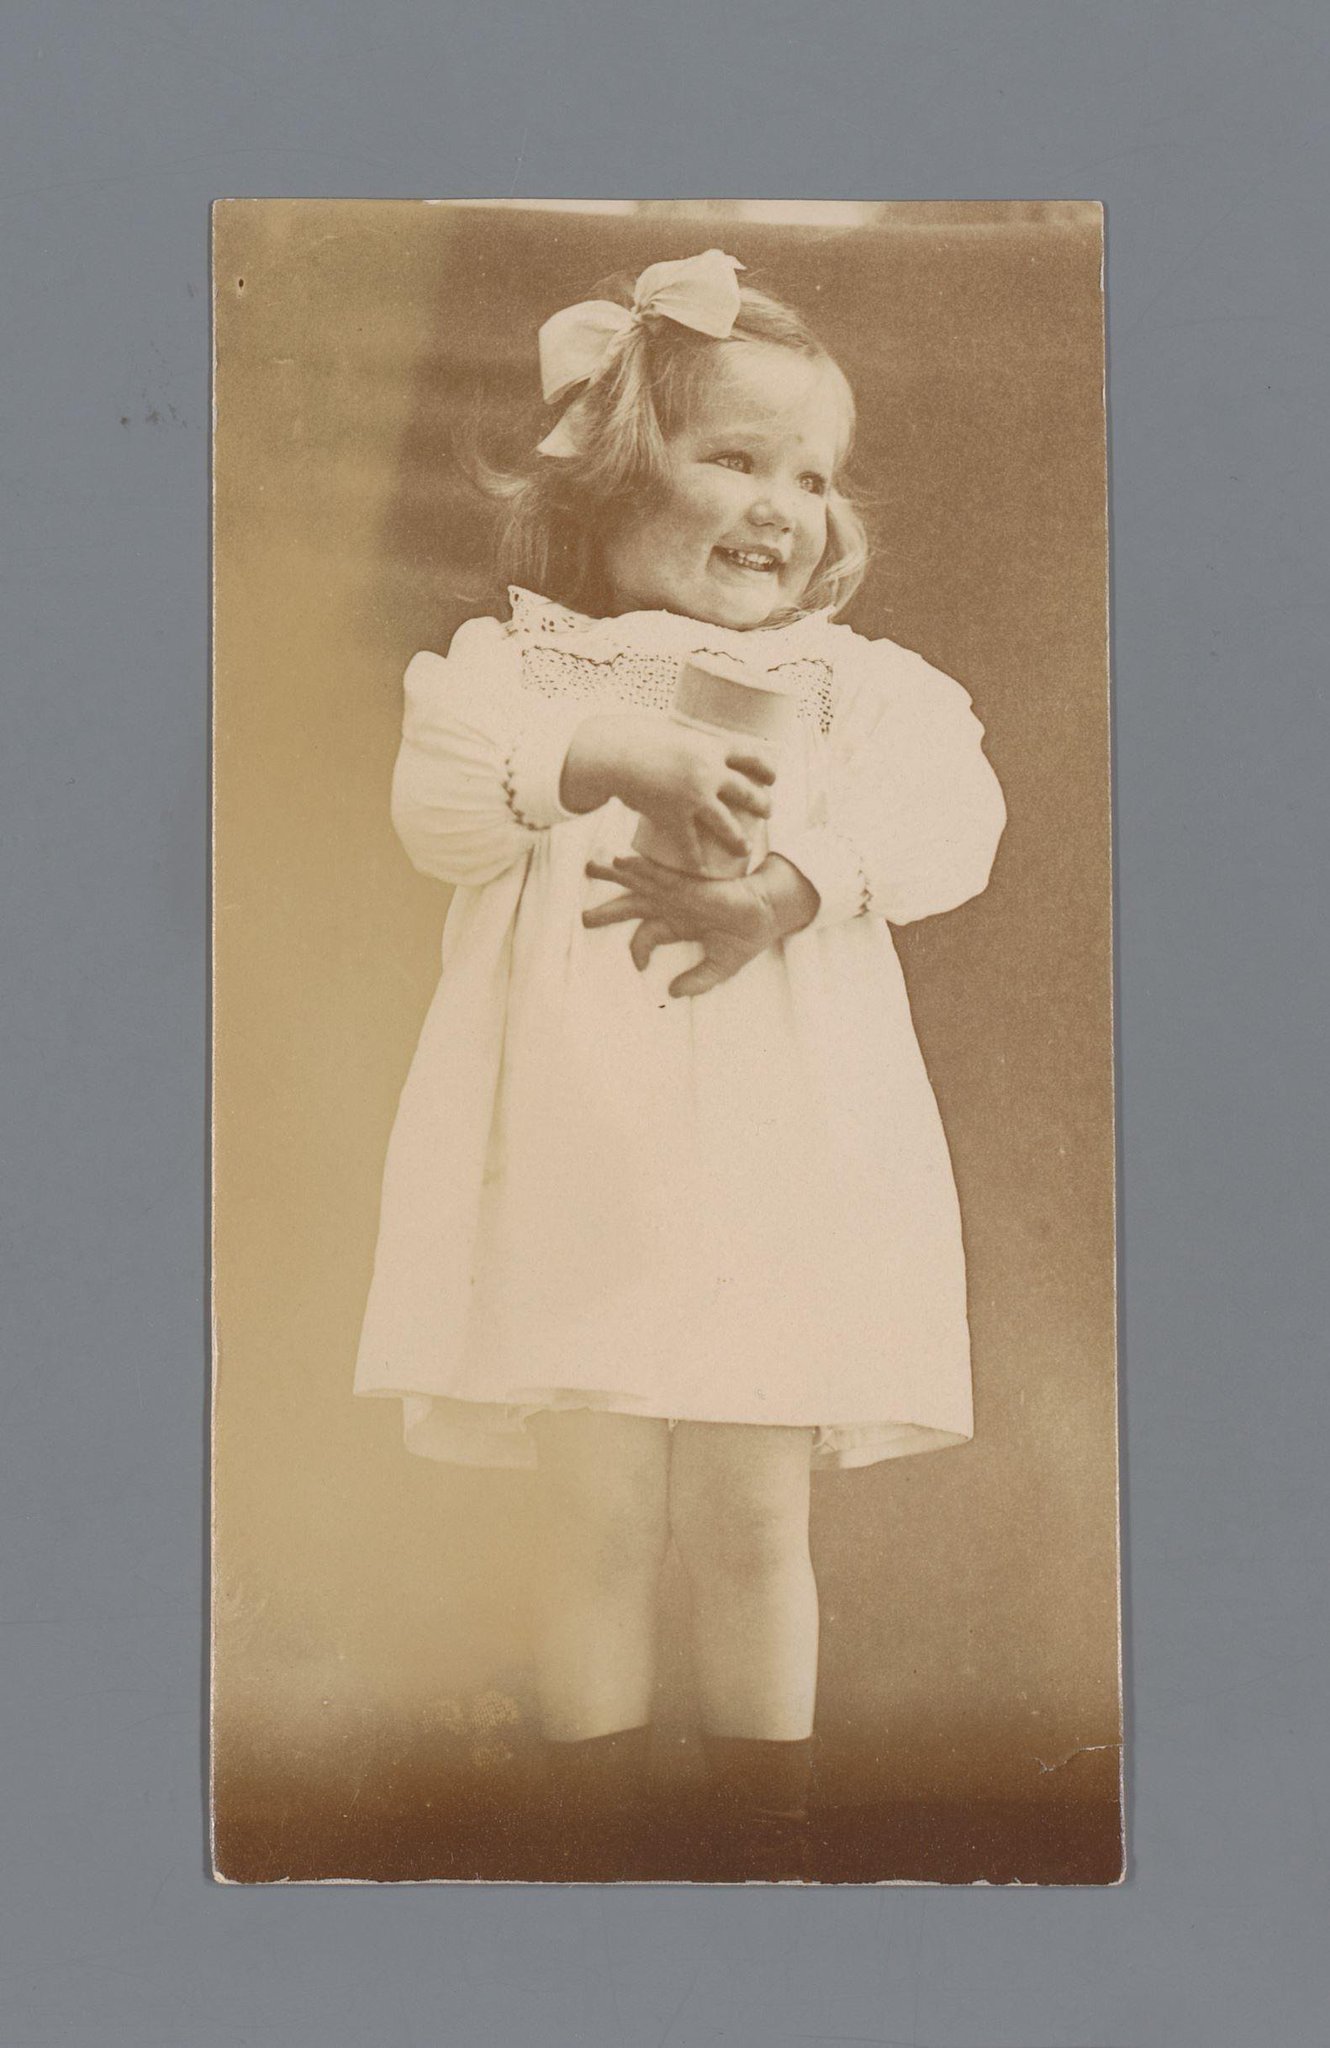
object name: photograph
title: Portret van Anne Madeleine van der Waals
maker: johannes diderik van der waals (1873-1971)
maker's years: 1873-1971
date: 1906-1910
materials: photographic support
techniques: gelatin silver print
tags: historical persons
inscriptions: annotation: ‘Anke’